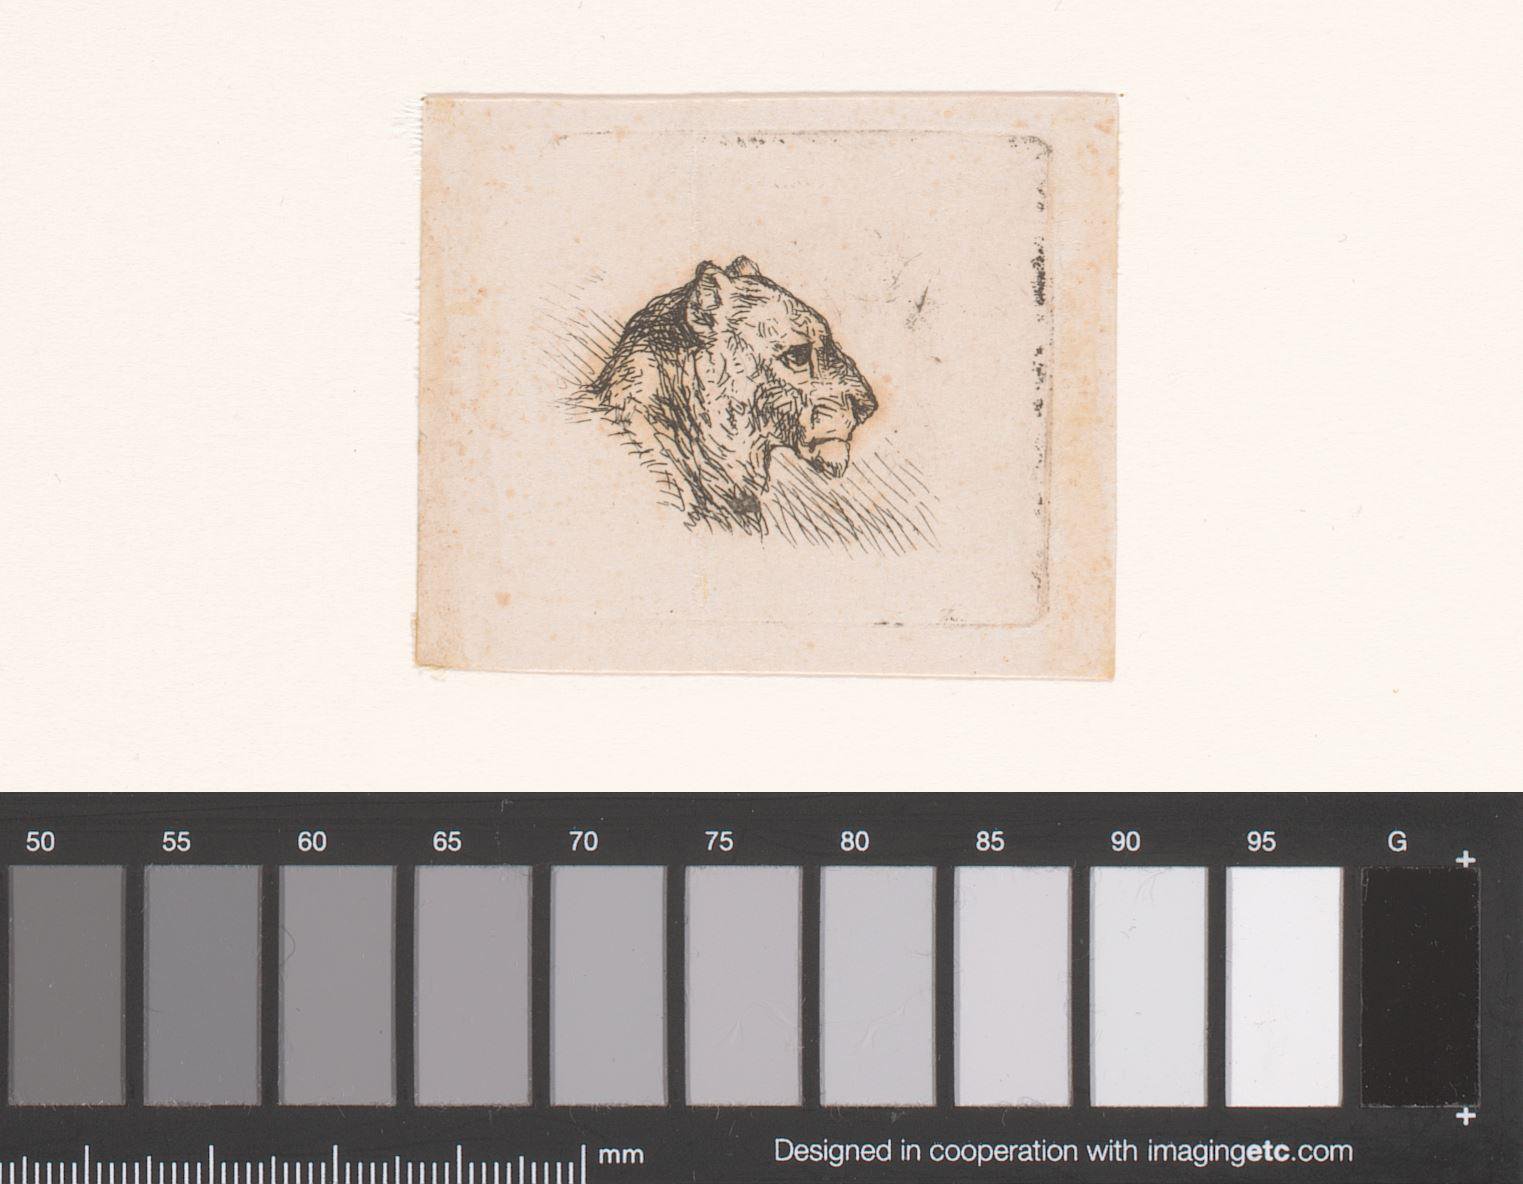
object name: print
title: Kop van een katachtige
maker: eugène verboeckhoven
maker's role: draughtsman, painter, print maker, printer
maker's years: 1798-1881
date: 1808-1881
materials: paper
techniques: drypoint, etching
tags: beasts of prey, predatory animals: tiger, beasts of prey, predatory animals: lion (+ female animal)